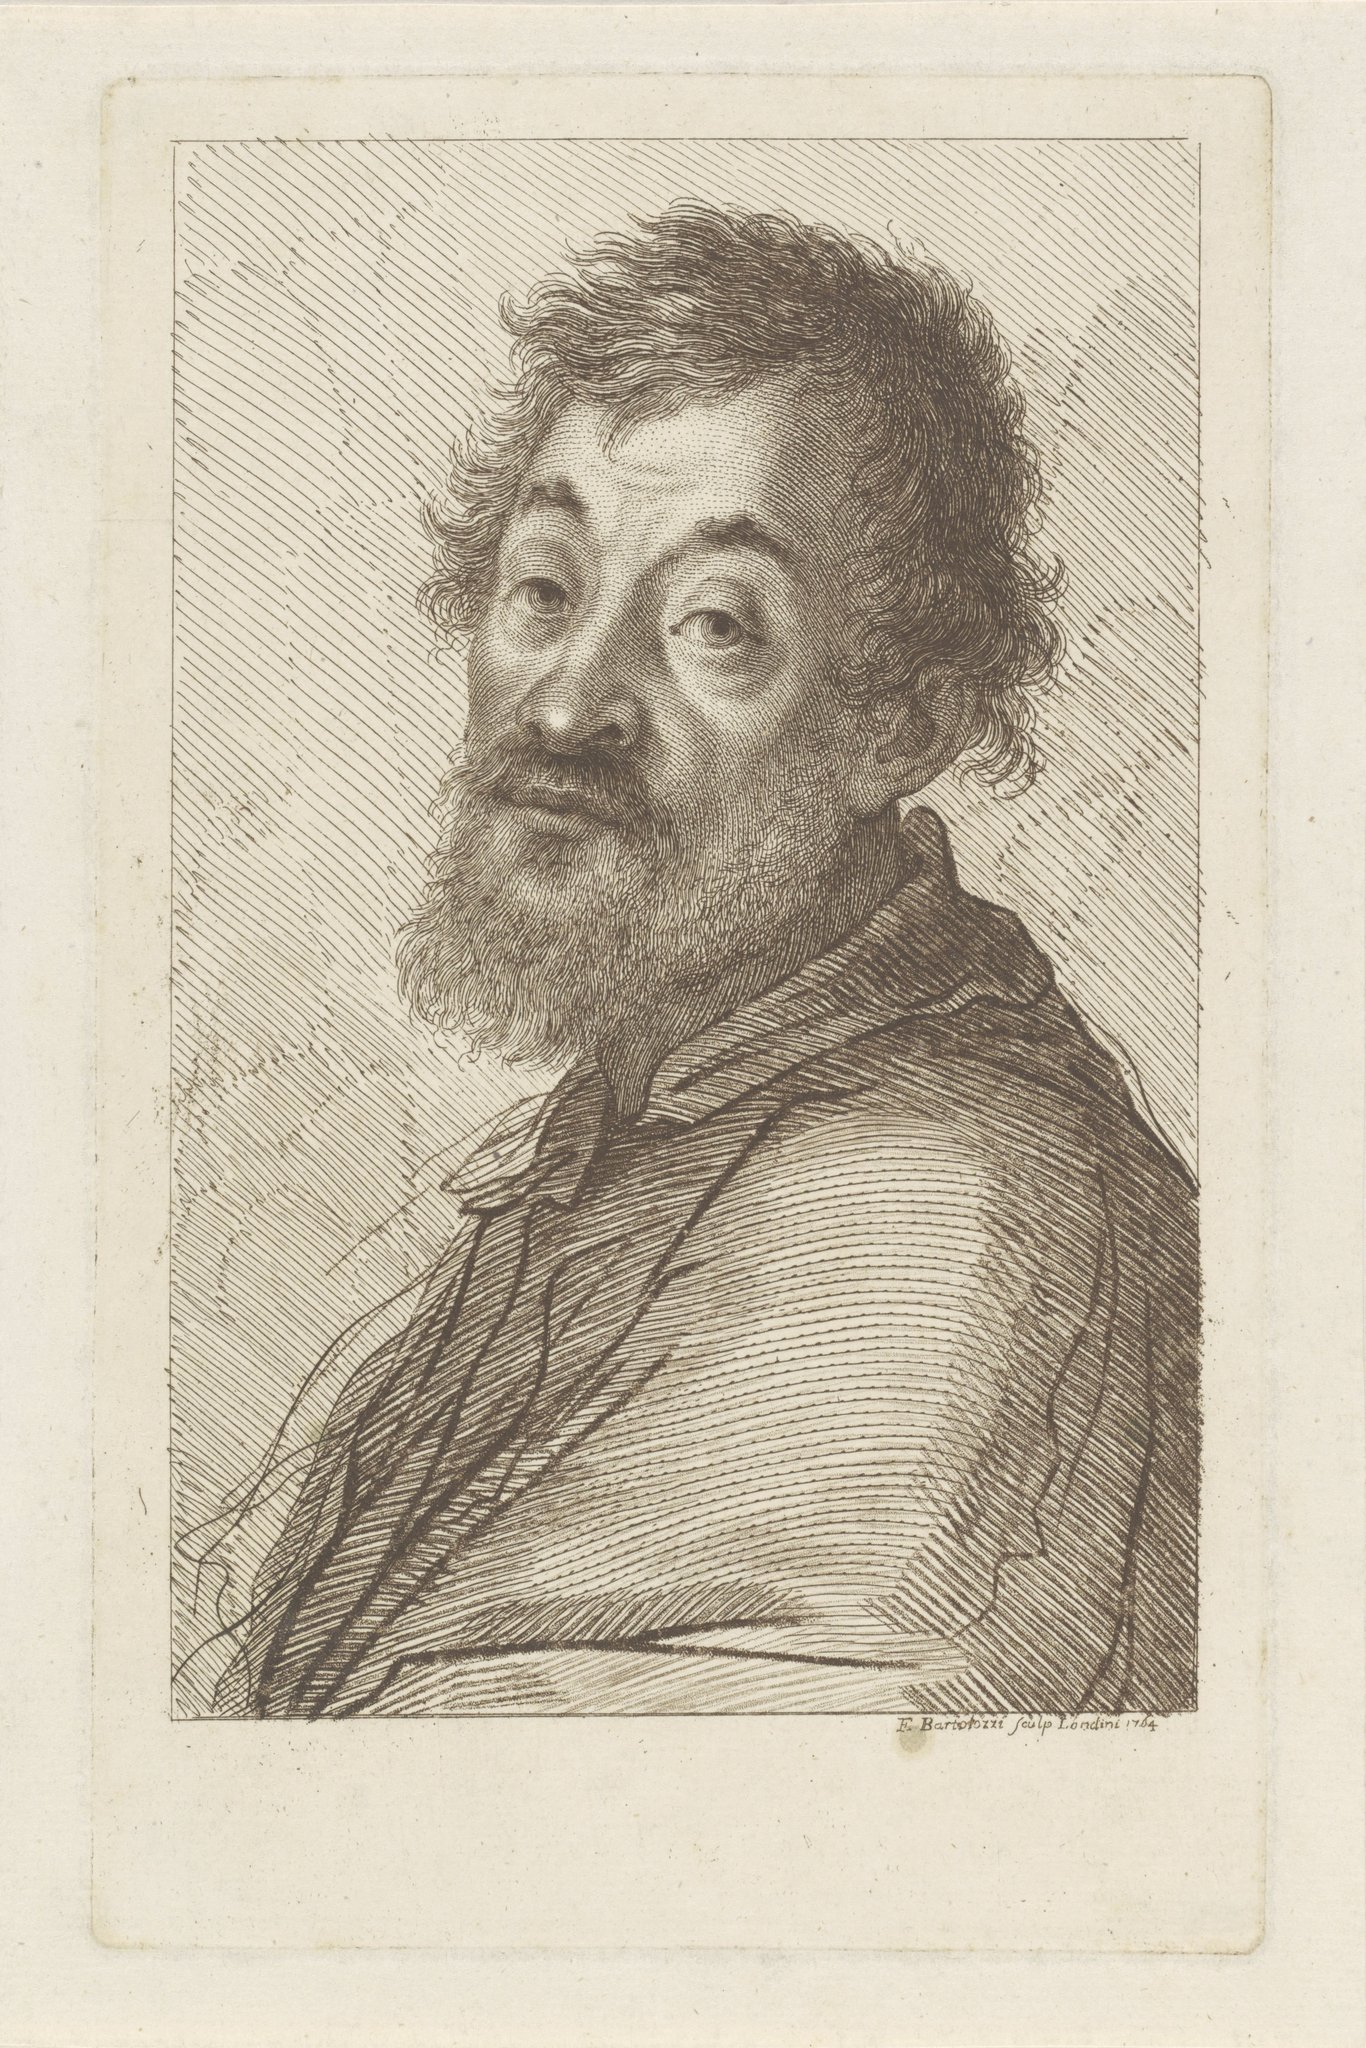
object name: print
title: Portret van een man met baard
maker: francesco bartolozzi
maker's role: draughtsman, print maker, publisher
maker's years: 1727-1815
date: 1764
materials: paper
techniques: printmaking, engraving, etching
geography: london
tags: rome, painter, print maker, draughtsman, giulio romano, anonymous historical person portrayed, portrait, self-portrait of artist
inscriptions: collector's mark: Lugt 2228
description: Portret van een man met baard, mogelijk Giulio Romano.